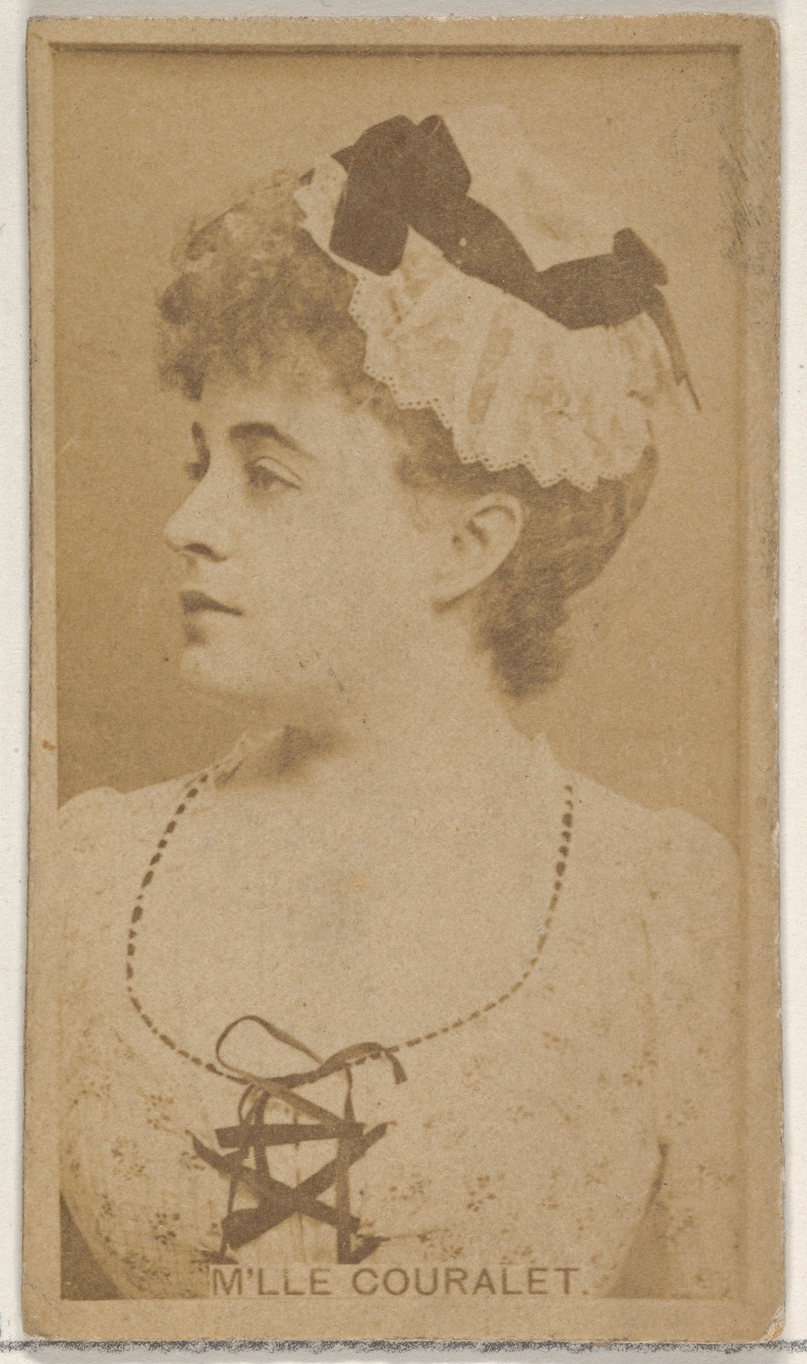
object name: photograph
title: M'lle Couralet, from the Actors and Actresses series (N45, Type 8) for Virginia Brights Cigarettes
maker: allen & ginter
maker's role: publisher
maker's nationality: american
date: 1888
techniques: albumen silver print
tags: portraits,profiles,women,actresses